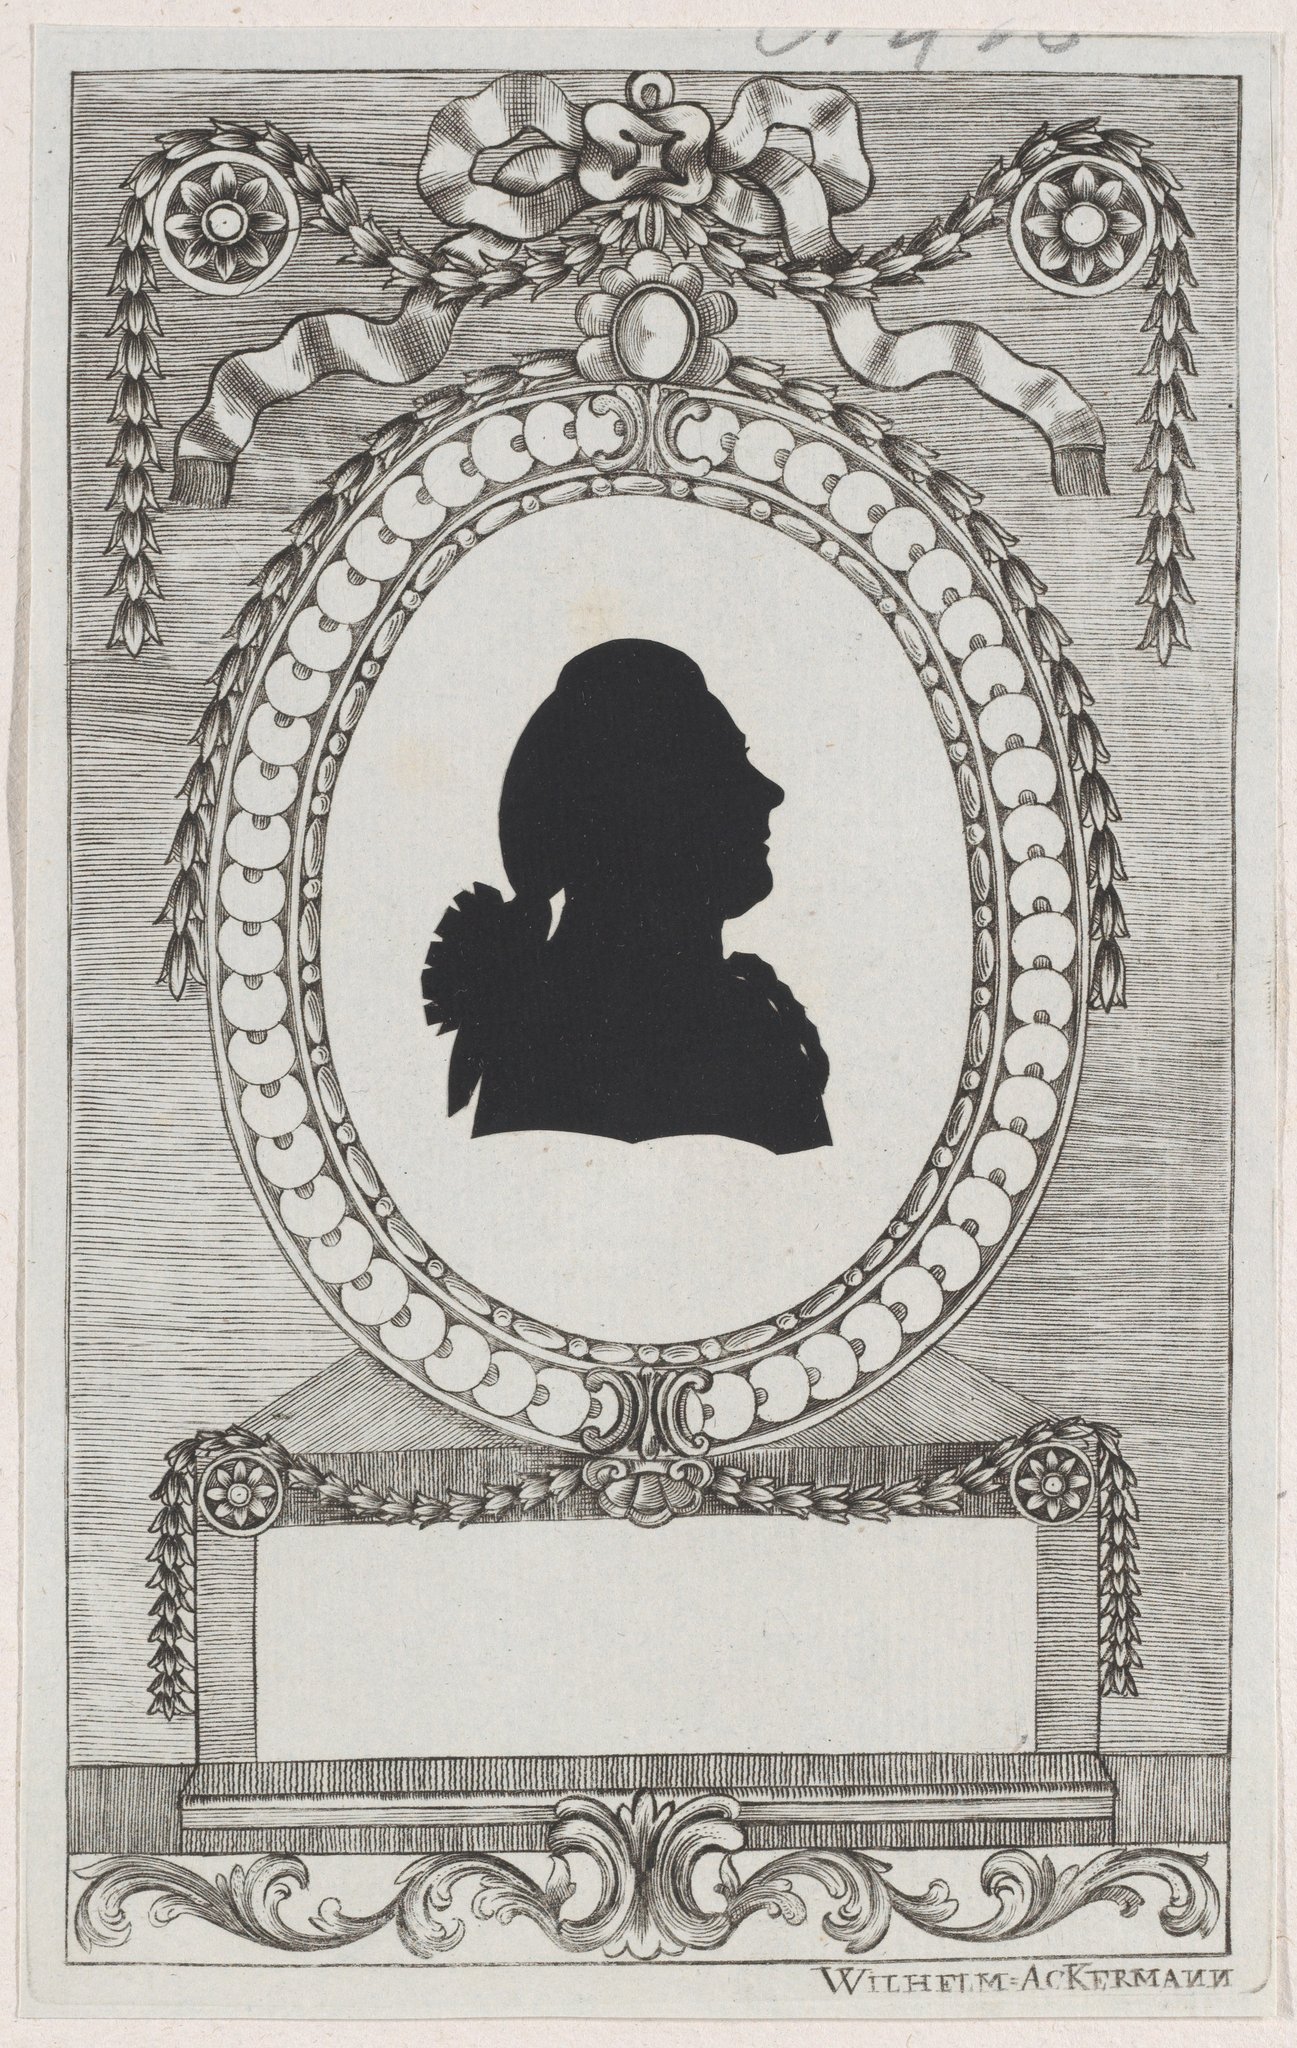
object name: print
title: Silhouette of Graf Leopold Kinigl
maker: wilhelm ackermann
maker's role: artist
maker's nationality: german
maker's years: 1764-1834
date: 1784-1834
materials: paper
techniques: cutting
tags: men